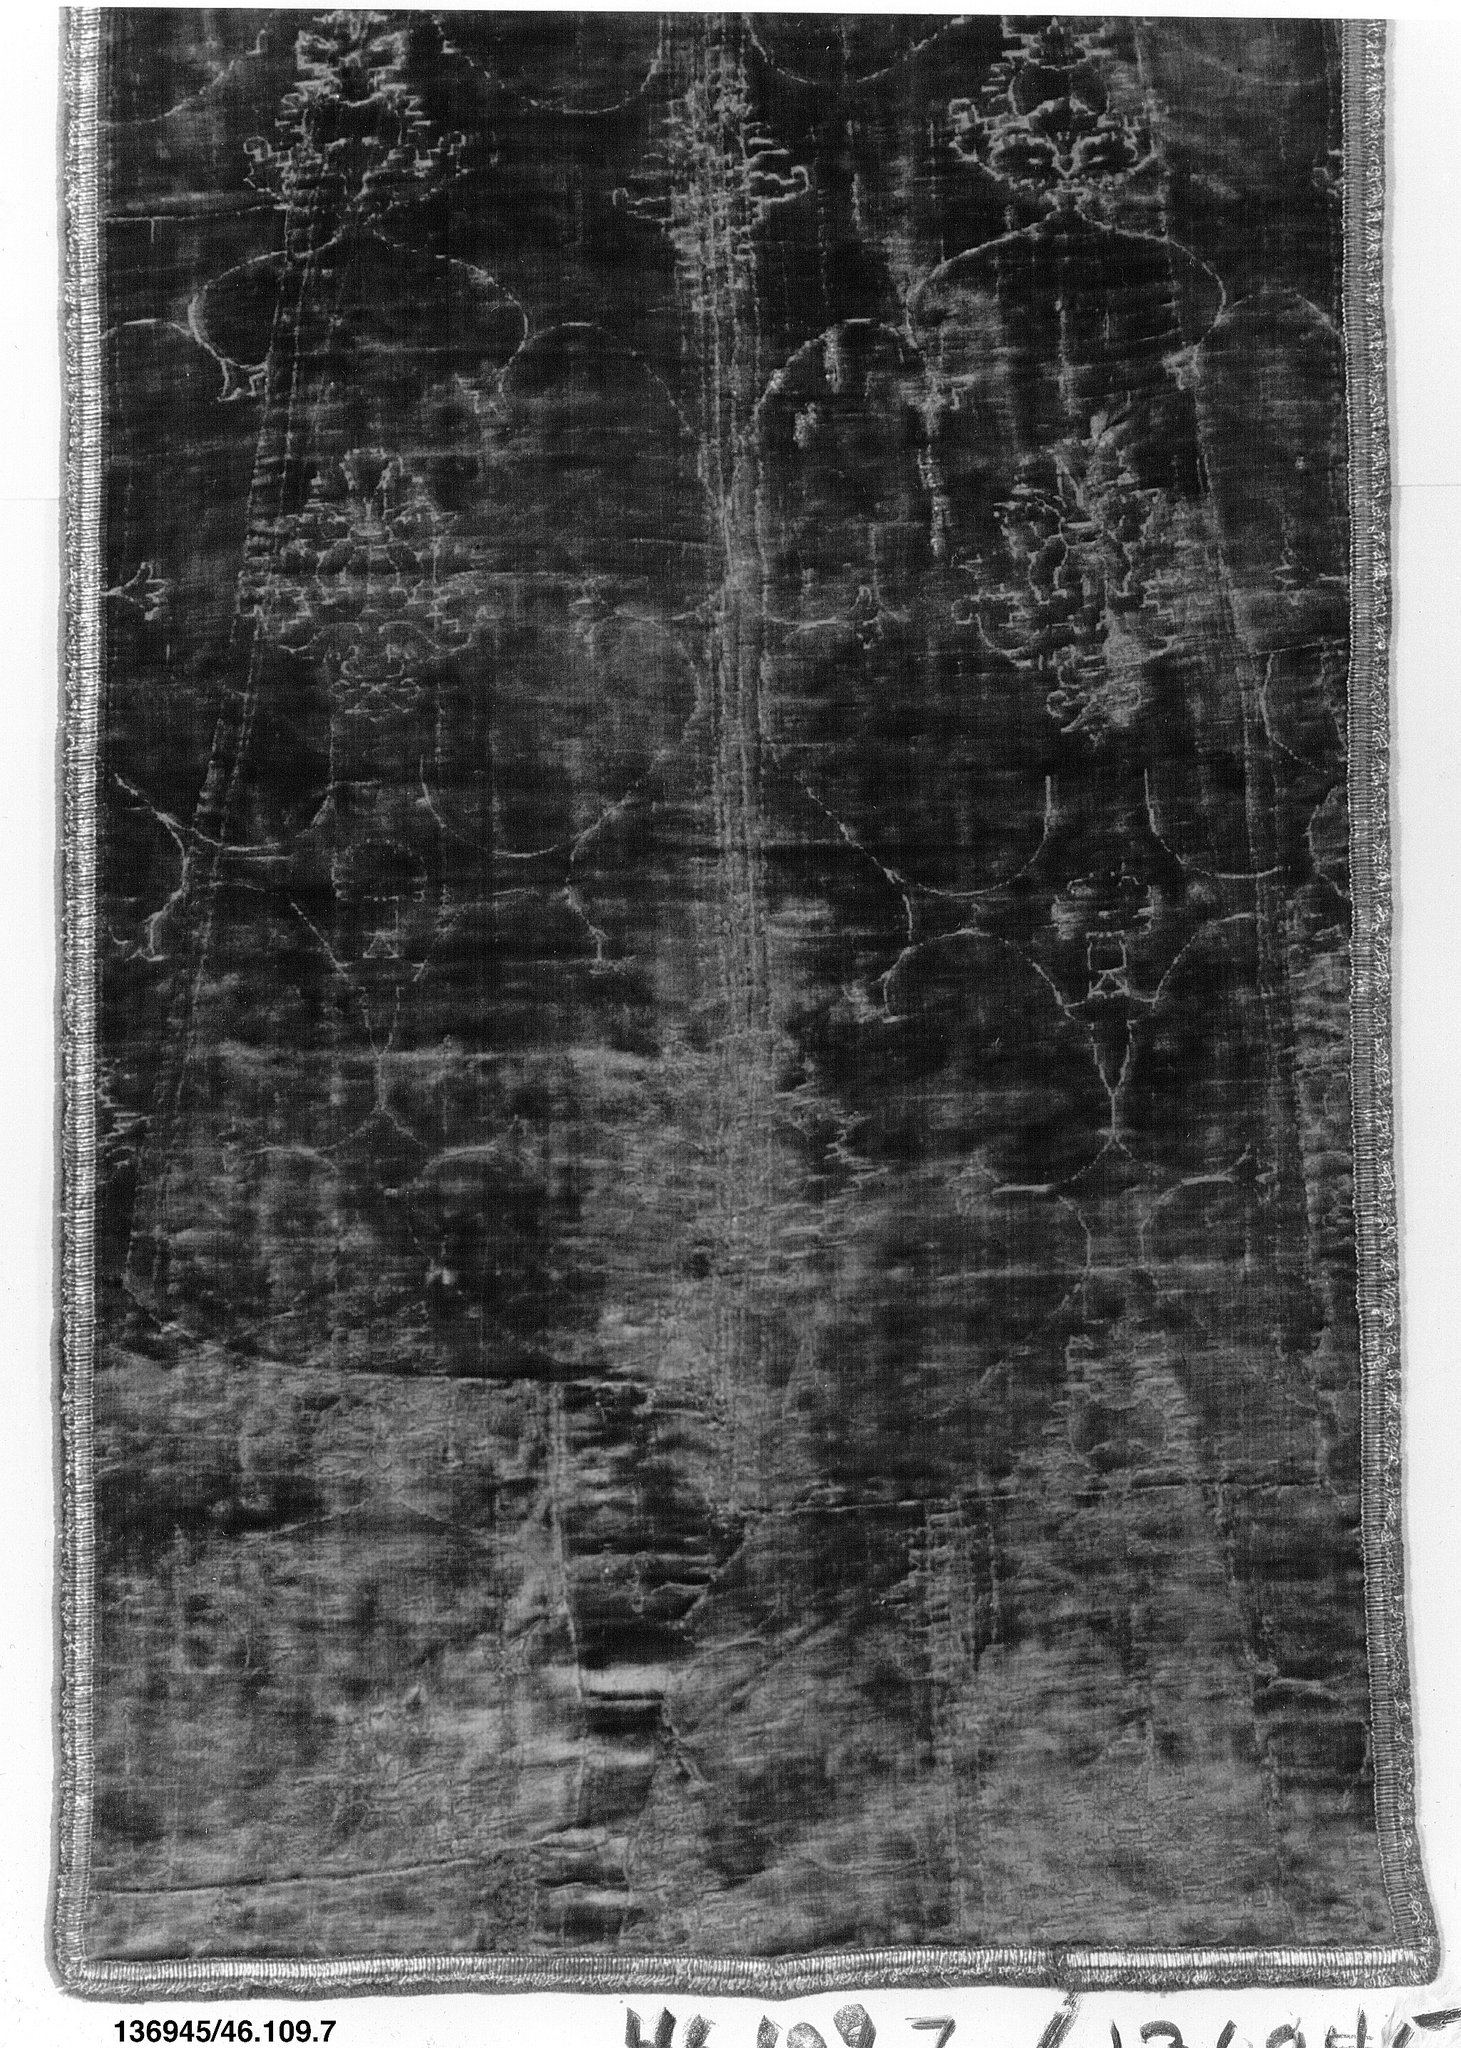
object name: piece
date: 1401-1500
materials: silk